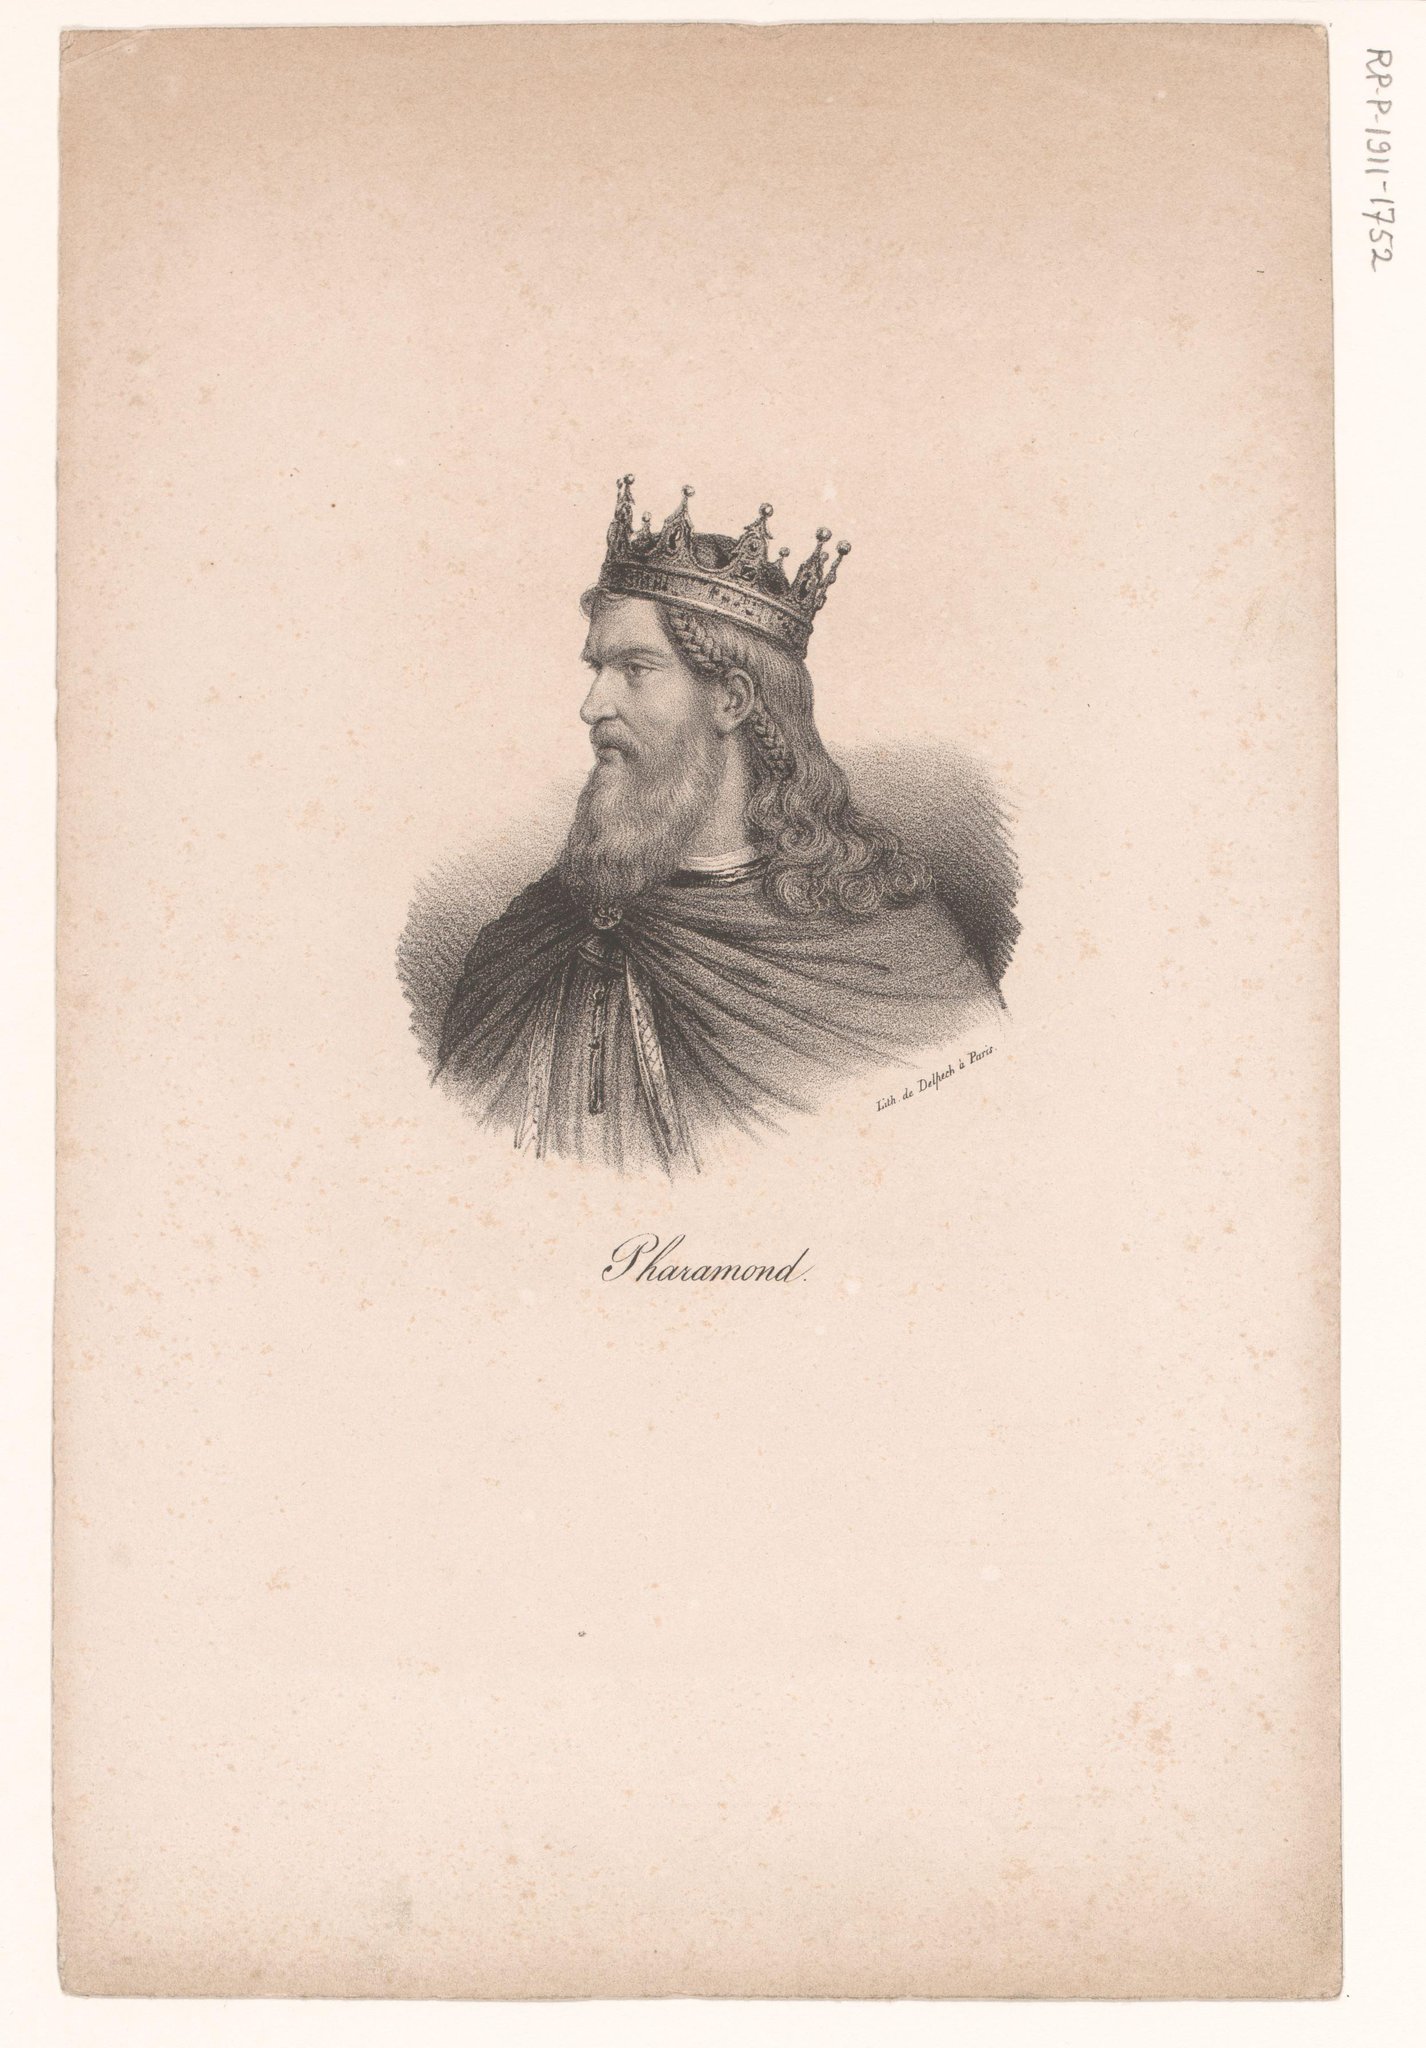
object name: print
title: Portret van koning Pharamond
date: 1818-1842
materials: paper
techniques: lithograph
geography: paris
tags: historical persons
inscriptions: collector's mark: Lugt 2228a